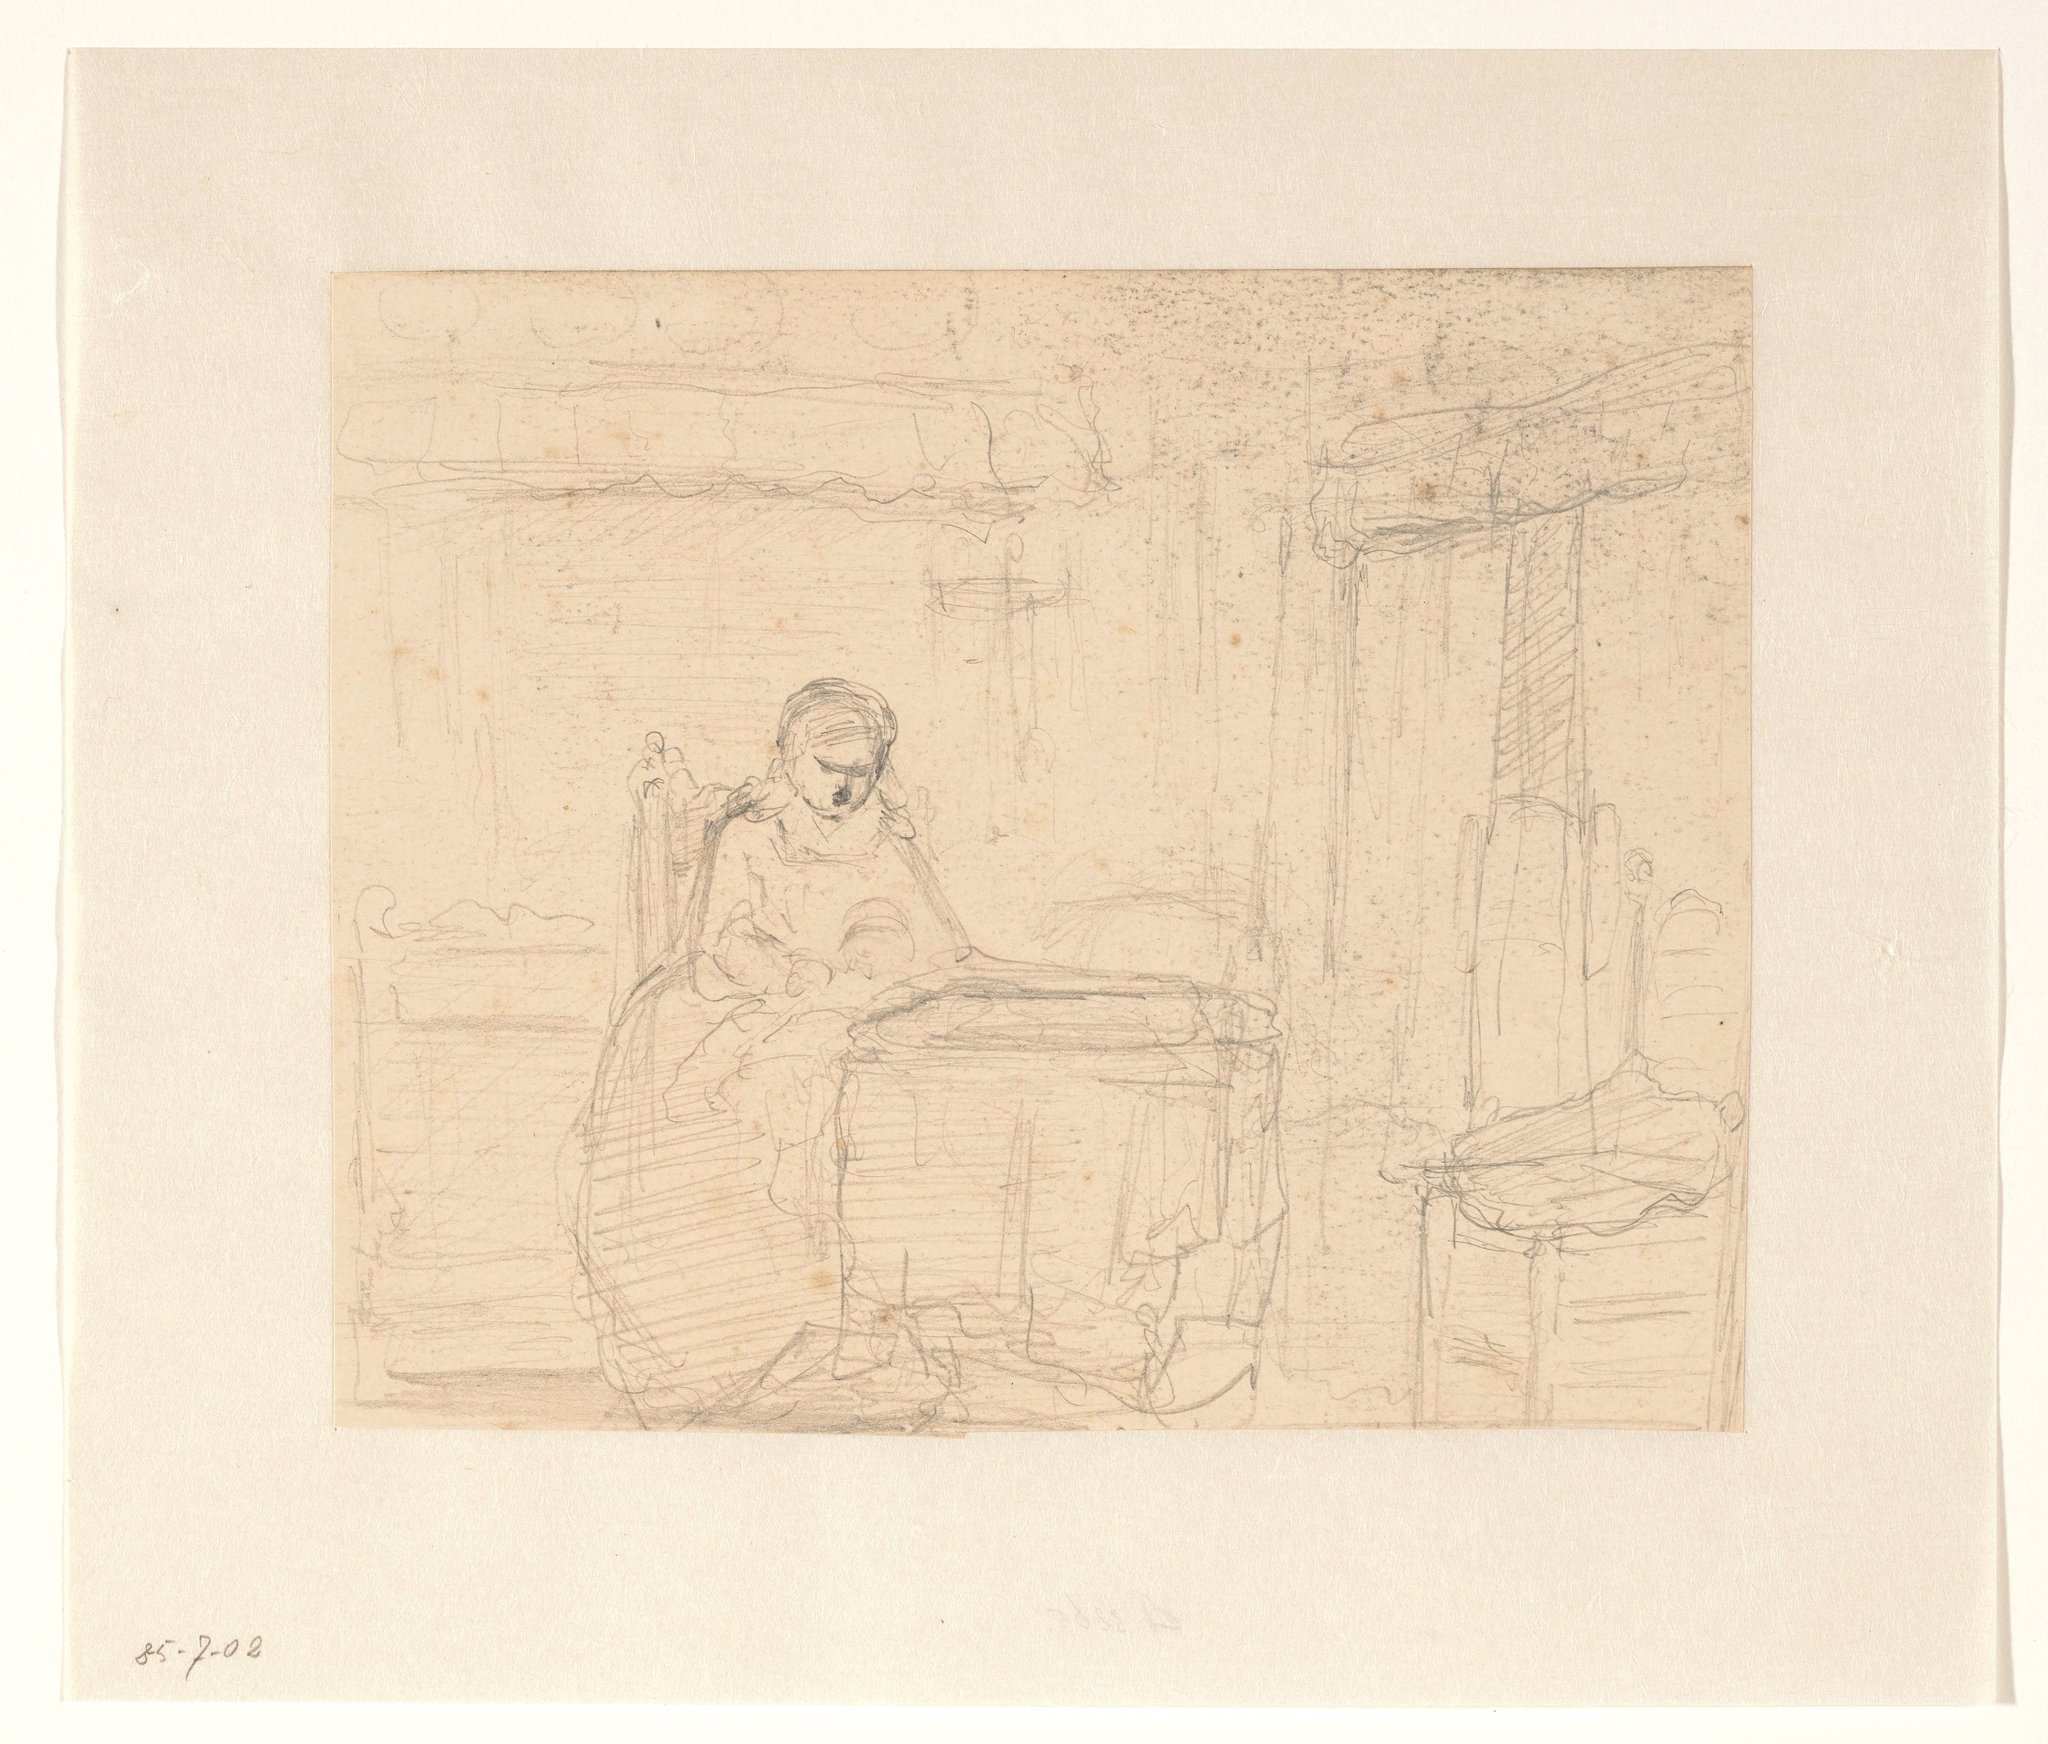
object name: drawing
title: Interieur met vrouw en kind bij een wieg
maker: hendrik valkenburg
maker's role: draughtsman, painter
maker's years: 1826-1896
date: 1836-1896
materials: paper, pencil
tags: adult woman, interior of the house, infant, baby ~ the ages of man